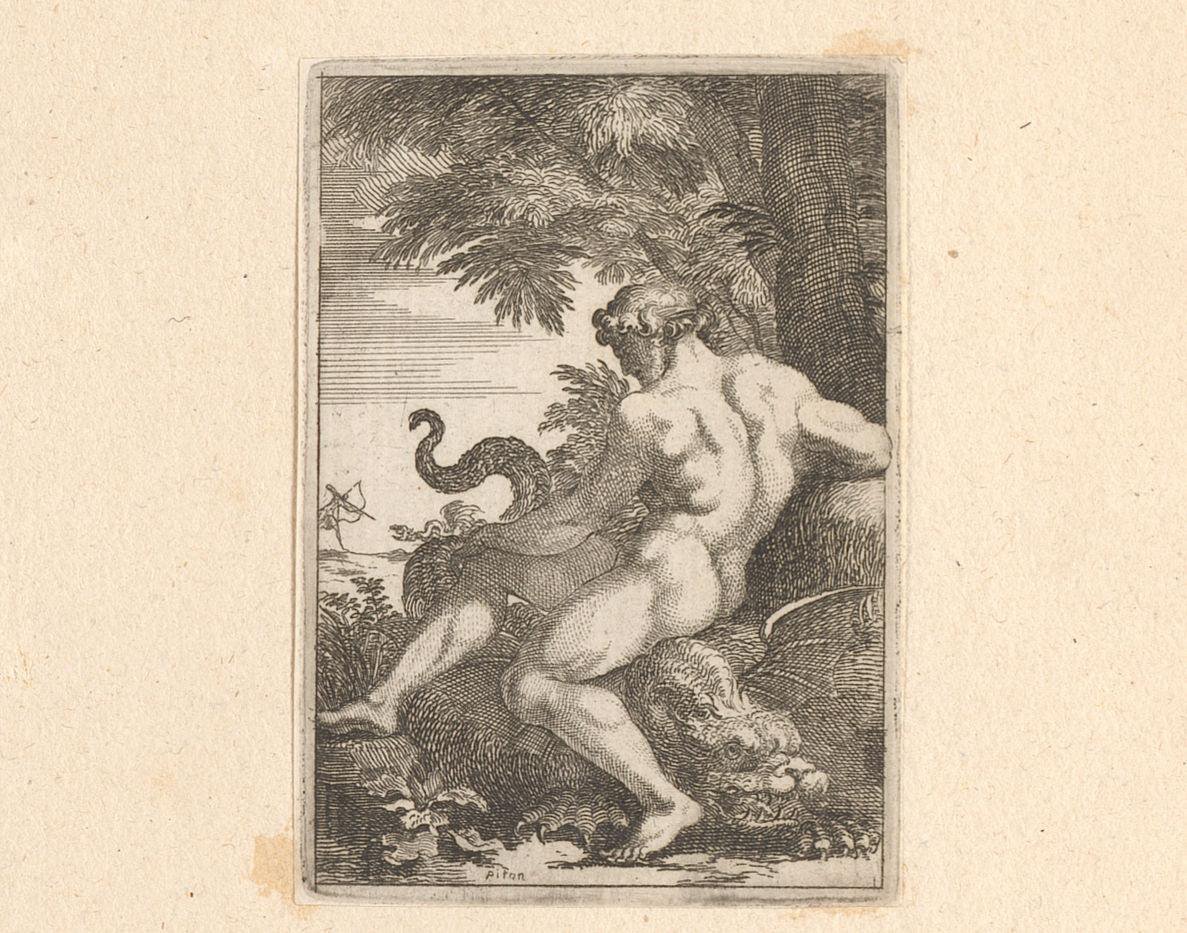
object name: print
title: Figures d'Academie pour apprendre à désiner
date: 1665-1673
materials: paper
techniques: etching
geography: paris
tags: apollo shoots python, the dragon, model-books ~ implements of painter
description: Maakt deel uit van een 32-delige serie met tekenvoorbeelden van goden en helden uit de klassieke oudheid. Een eerste editie werd in 1673 uitgegeven en een tweede in 1684 door Nicolas Langlois.